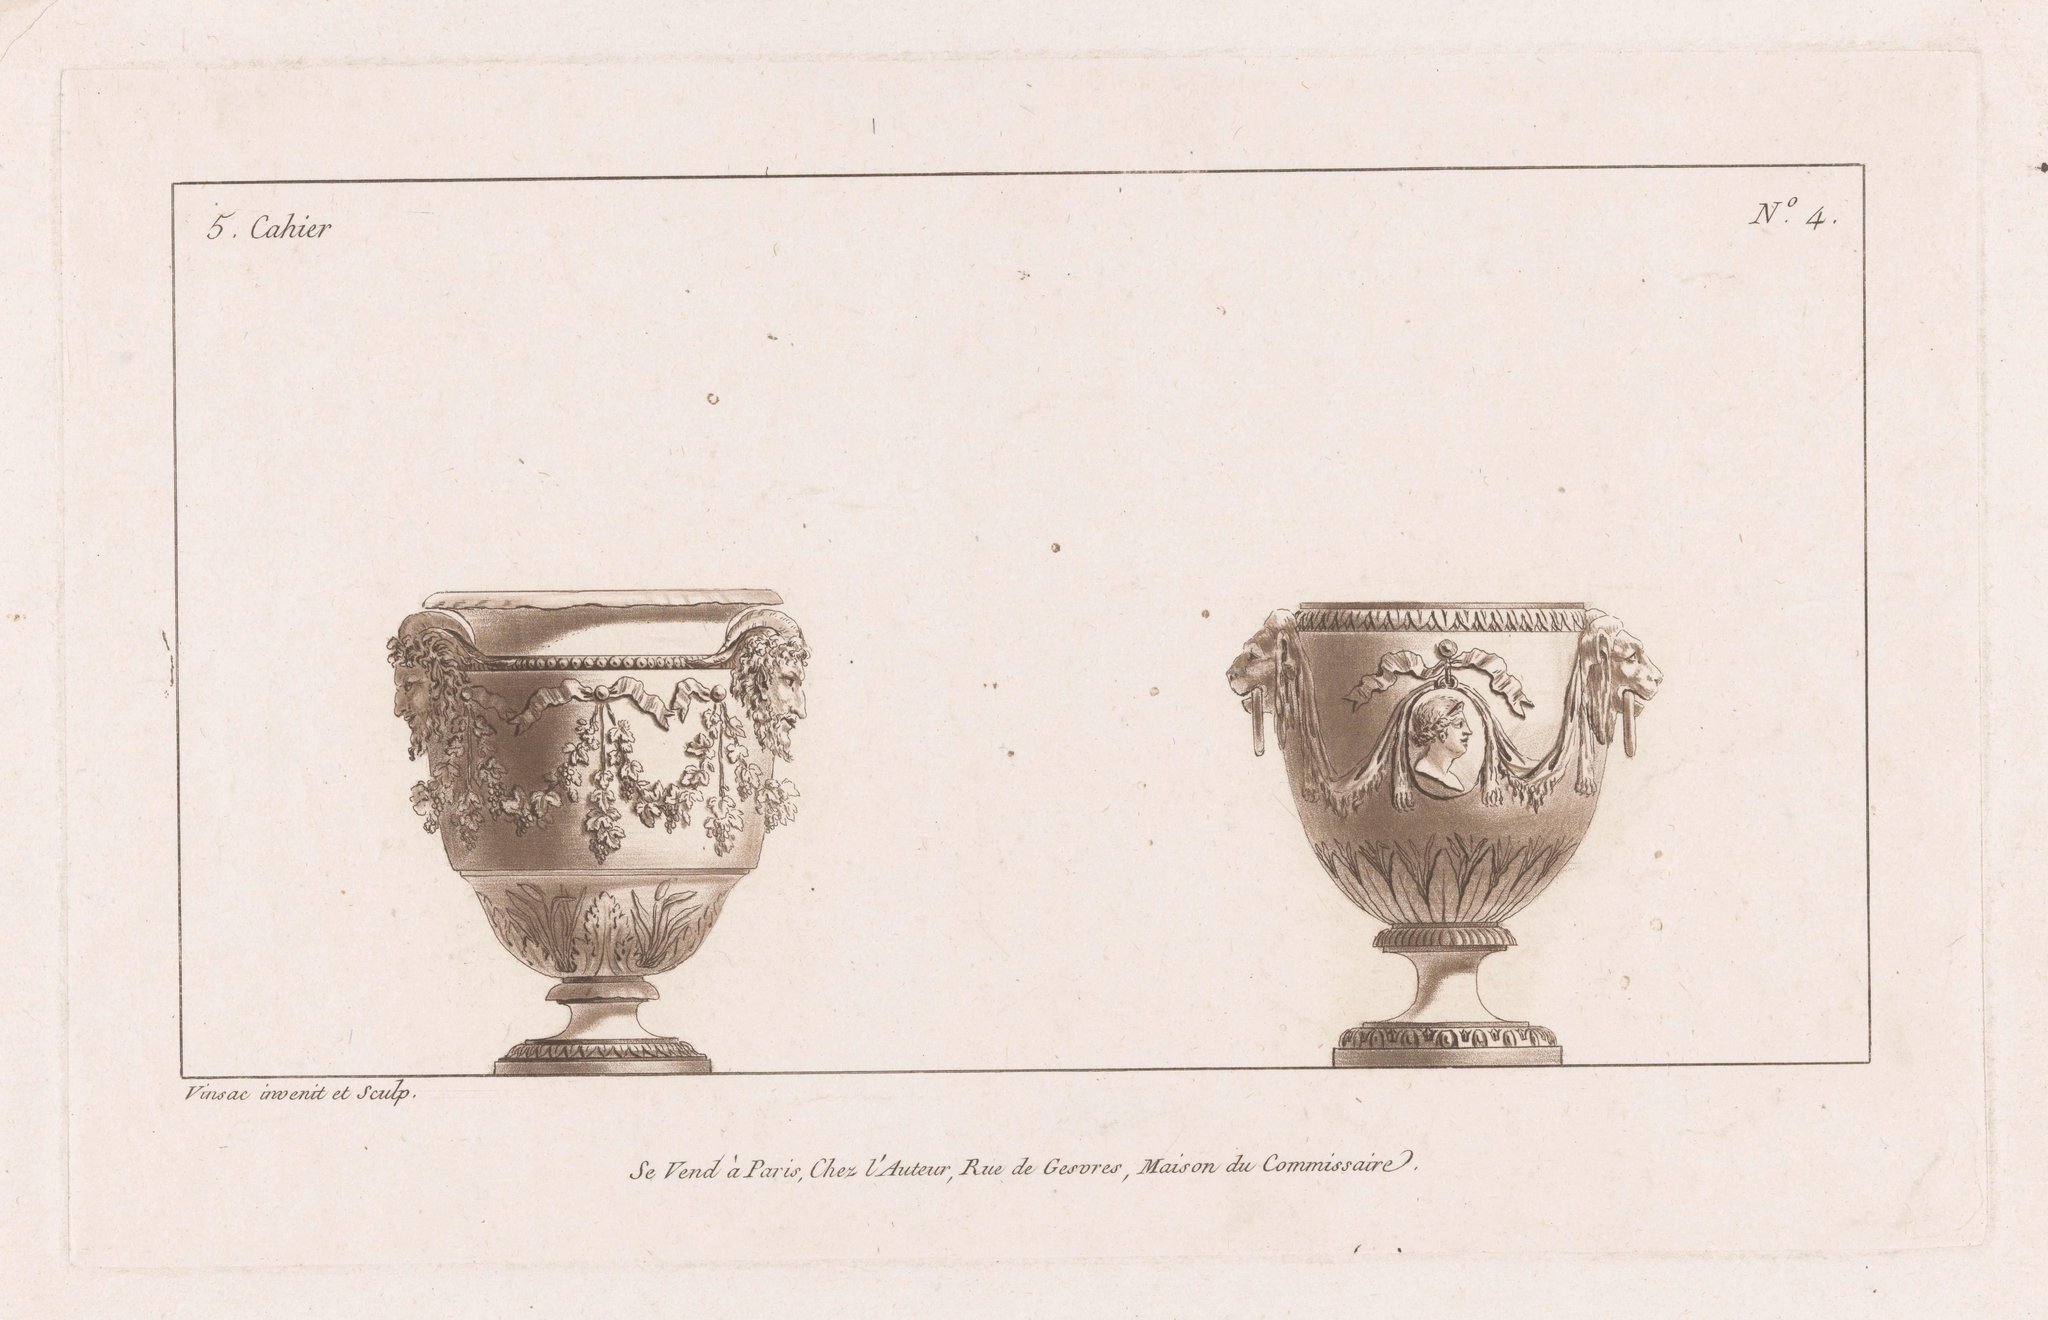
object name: print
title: Wijnkoelers met sater- en leeuwenkoppen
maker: claude dominique vinsac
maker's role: print maker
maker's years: 1749-1800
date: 1759-1800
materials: paper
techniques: aquatint, etching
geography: paris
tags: lion's head ~ ornament, satyr(s) (in general), wine-cooler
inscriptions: collector's mark: Lugt 2228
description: Links een wijnkoeler met guirlandes en twee saterkoppen. Rechts een wijnkoeler met guirlandes, een medaillon met portret en profil en twee leeuwenkoppen.